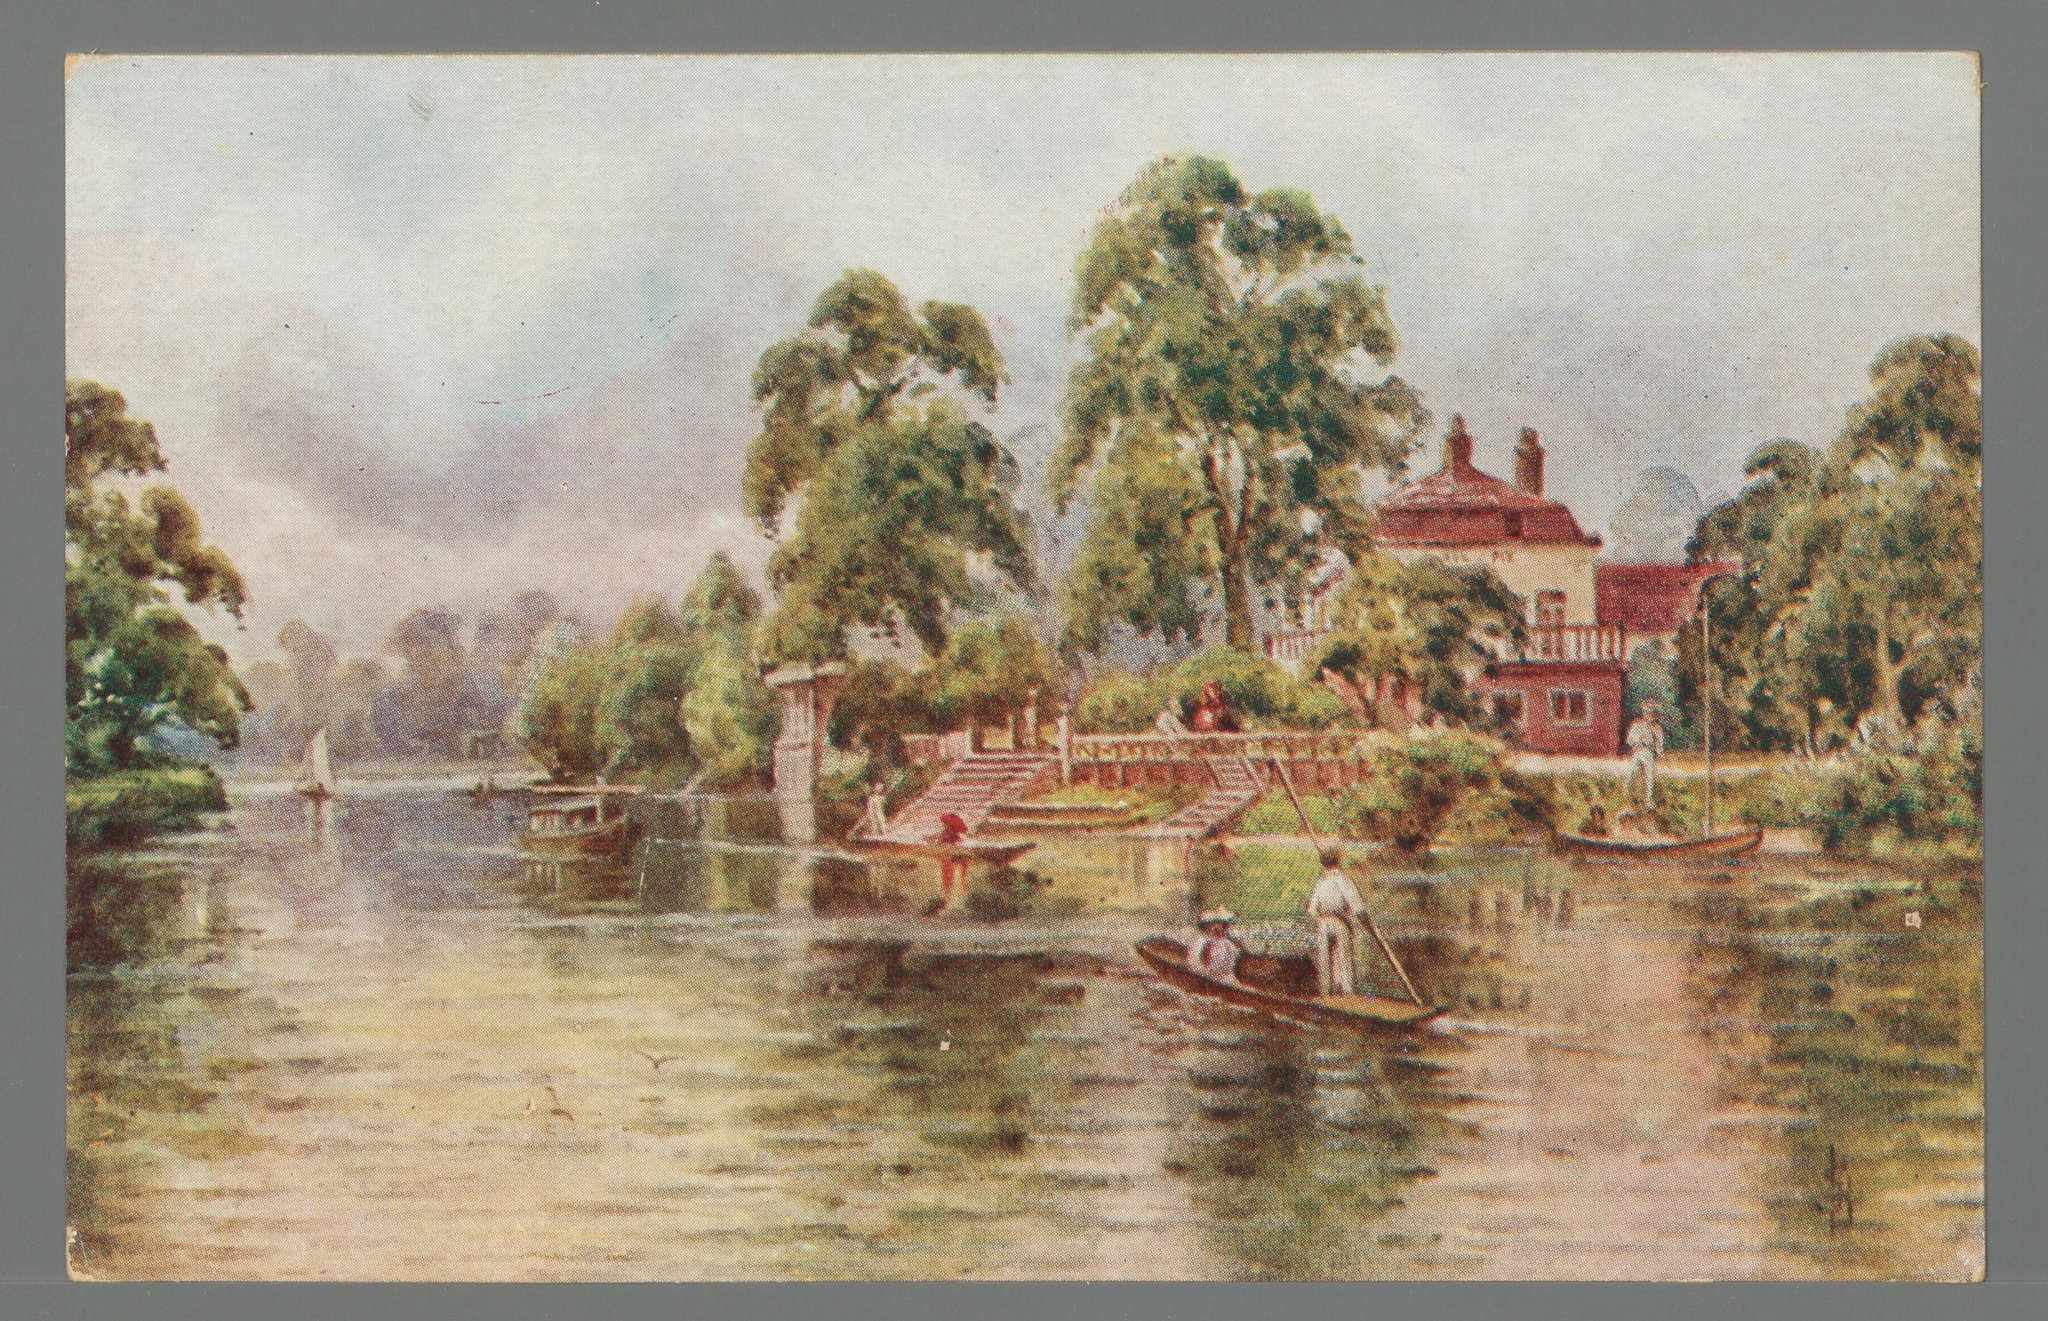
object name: ansichtkaart, prentbriefkaart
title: Eel Pie Island, Twickenham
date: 1902-1930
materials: cardboard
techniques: color autotype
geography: richmond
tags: island, canals, waters (in city), thames